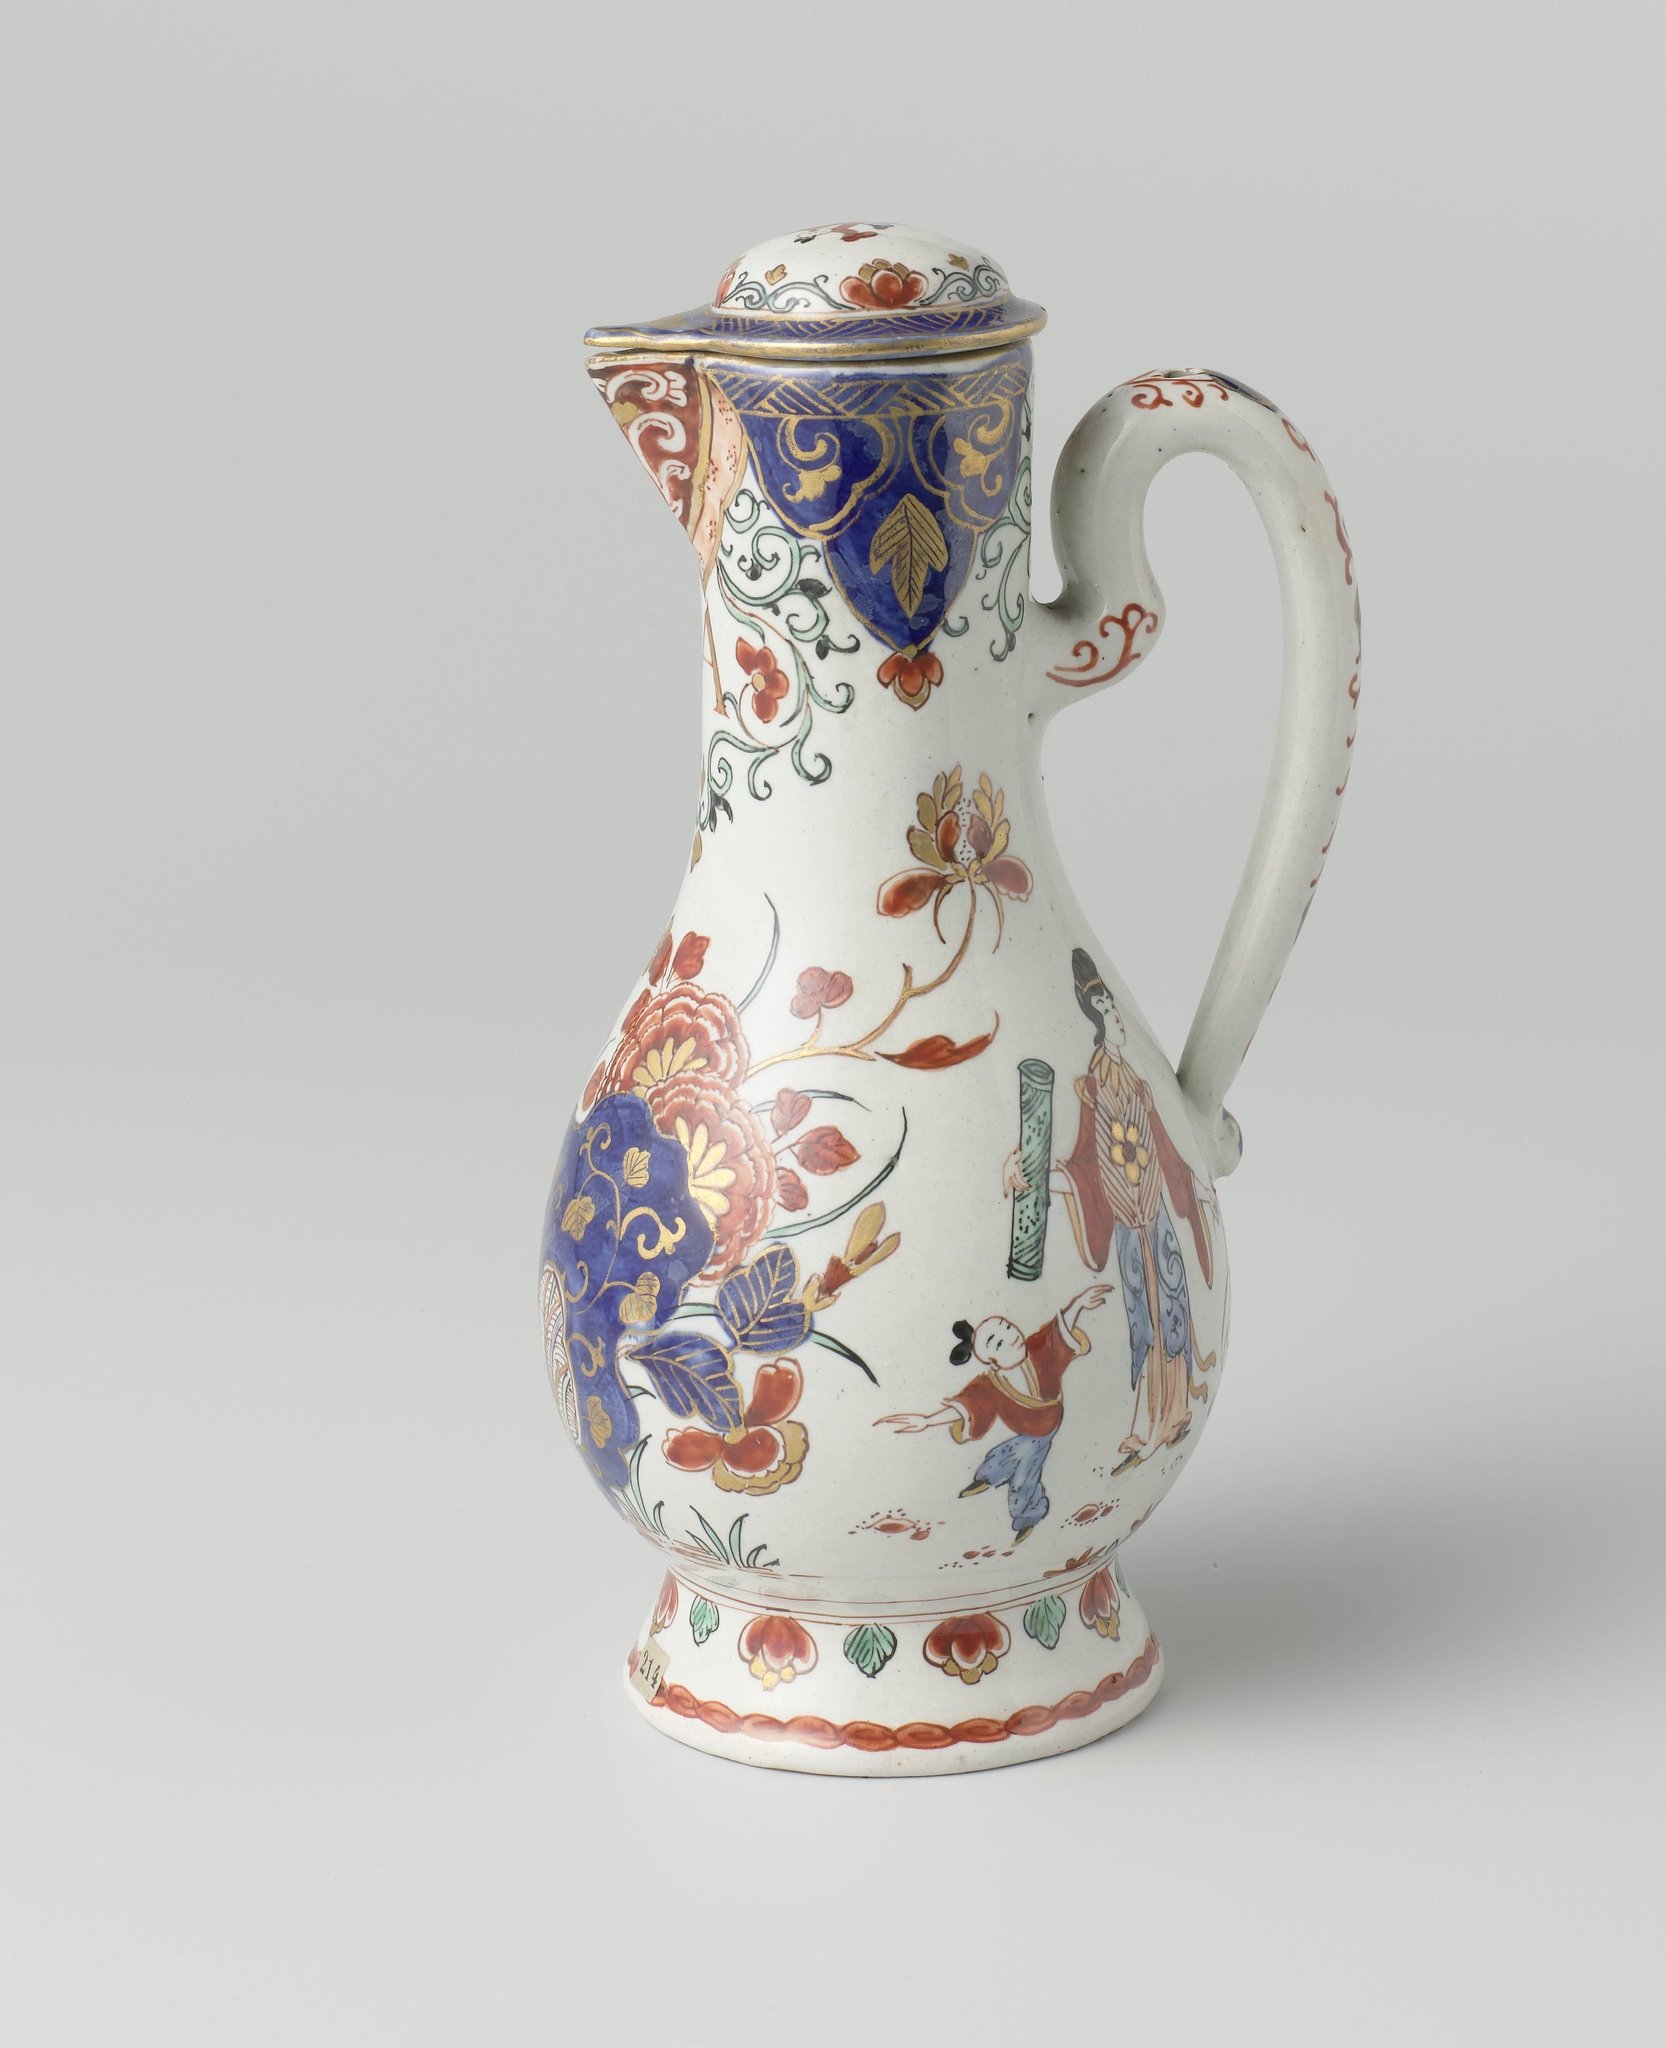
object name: ewer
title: Kan, onderdeel van een olie- en azijnstel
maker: Anonymous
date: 1705-1725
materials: earthenware, glaze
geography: delft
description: Kan van een olie- en azijnstel van faïence. Veelkleurig beschilderd. De kan is onderdeel van een olie- en azijnstel.